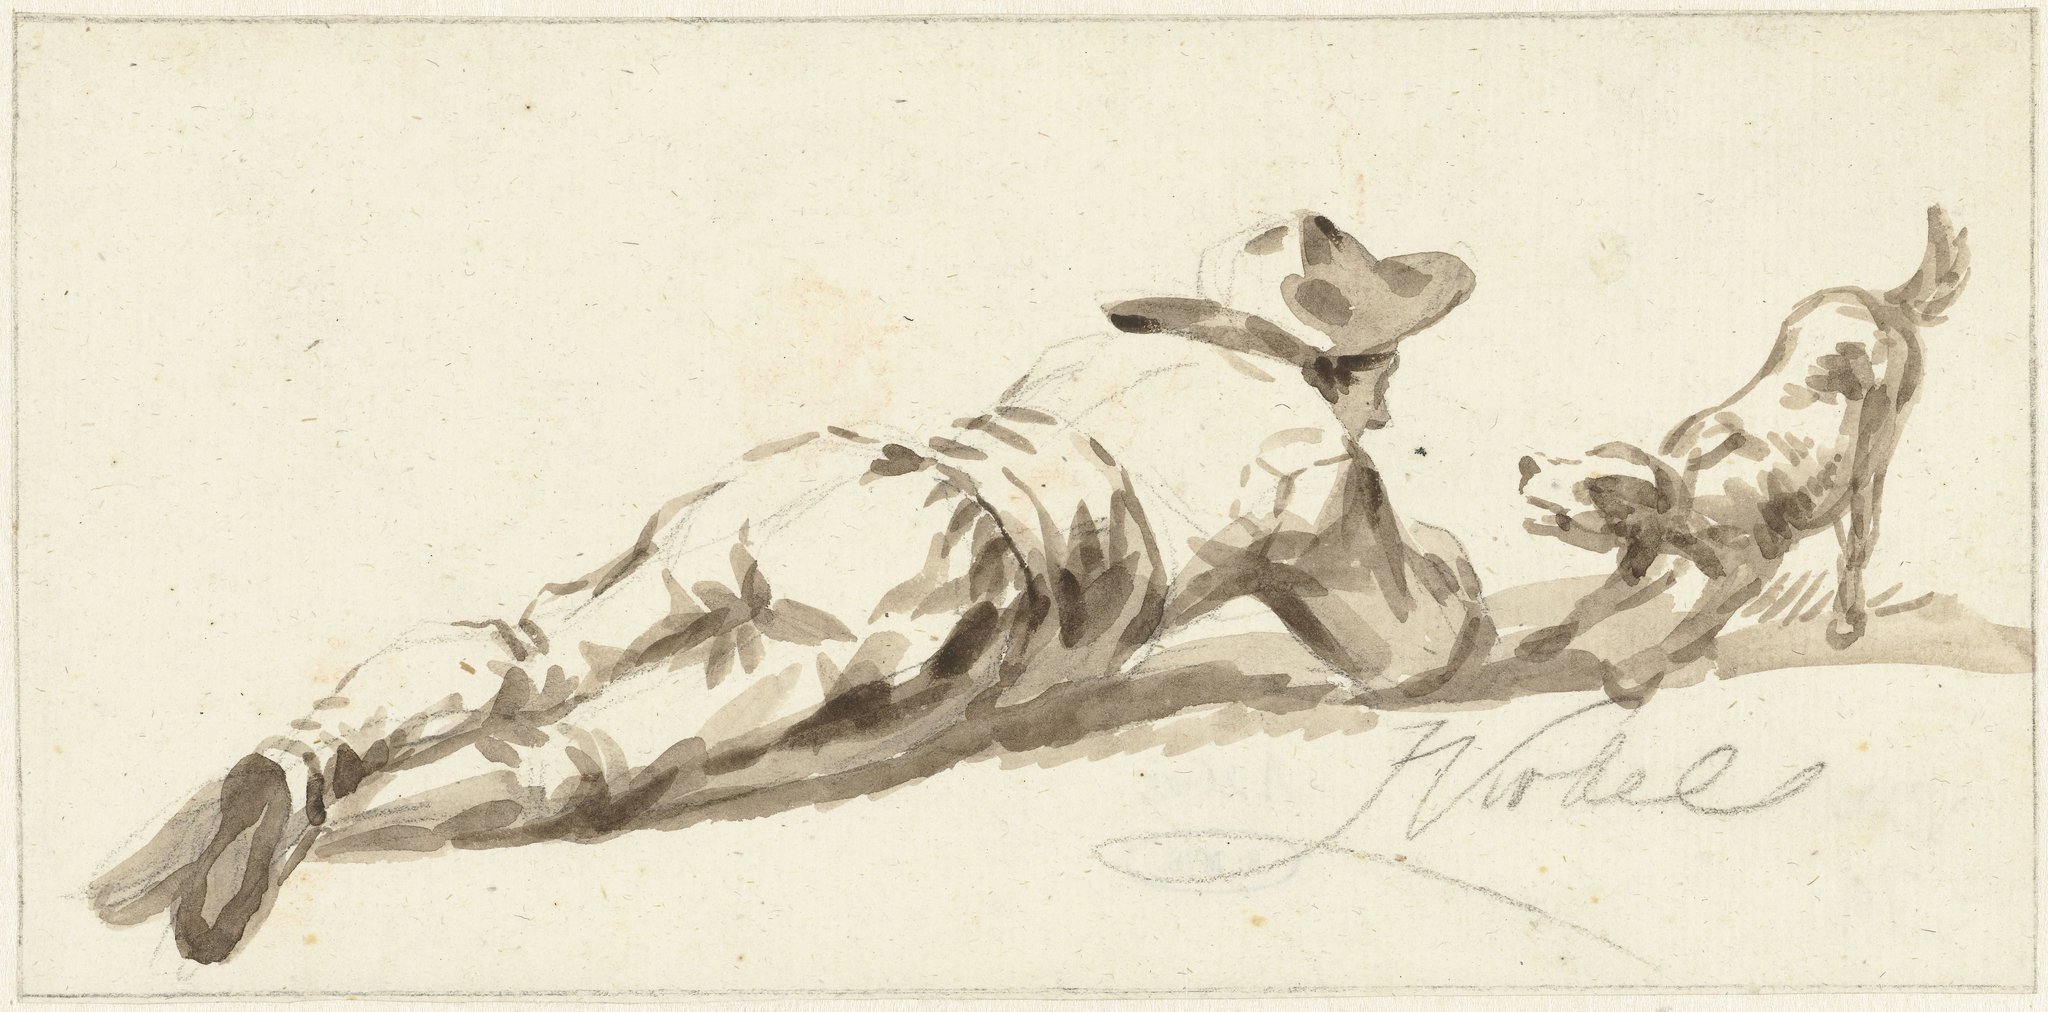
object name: drawing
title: Liggende jongen met een hond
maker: jan kobell (ii)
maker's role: draughtsman, painter, print maker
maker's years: 1778-1814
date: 1788-1814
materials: chalk, paper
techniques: brush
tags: dog